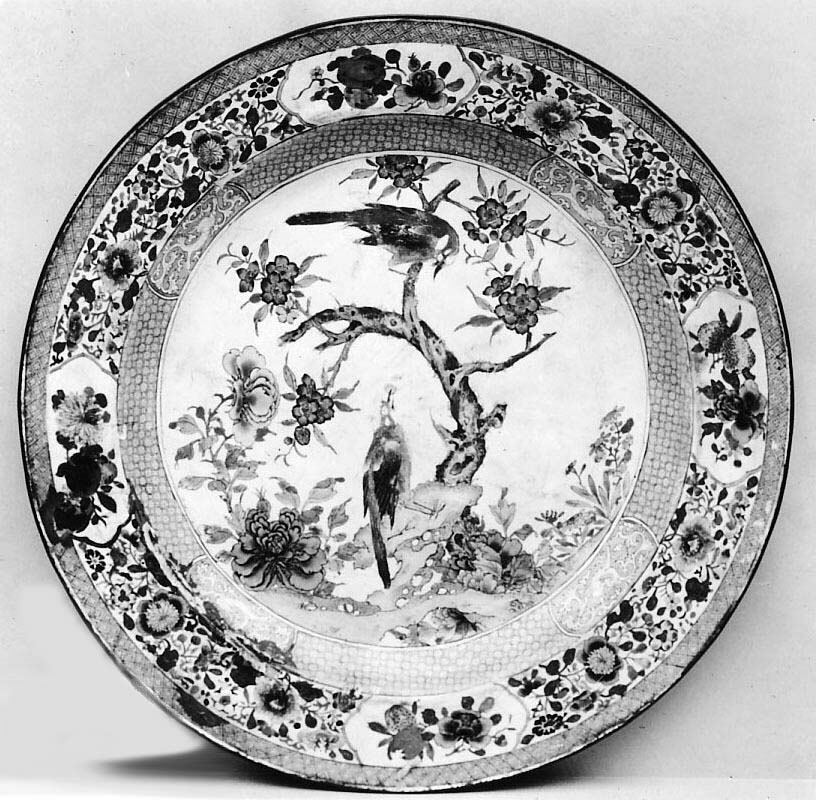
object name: plate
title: Large Plate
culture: chinese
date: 1736-1795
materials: enamel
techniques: painting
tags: birds,flowers